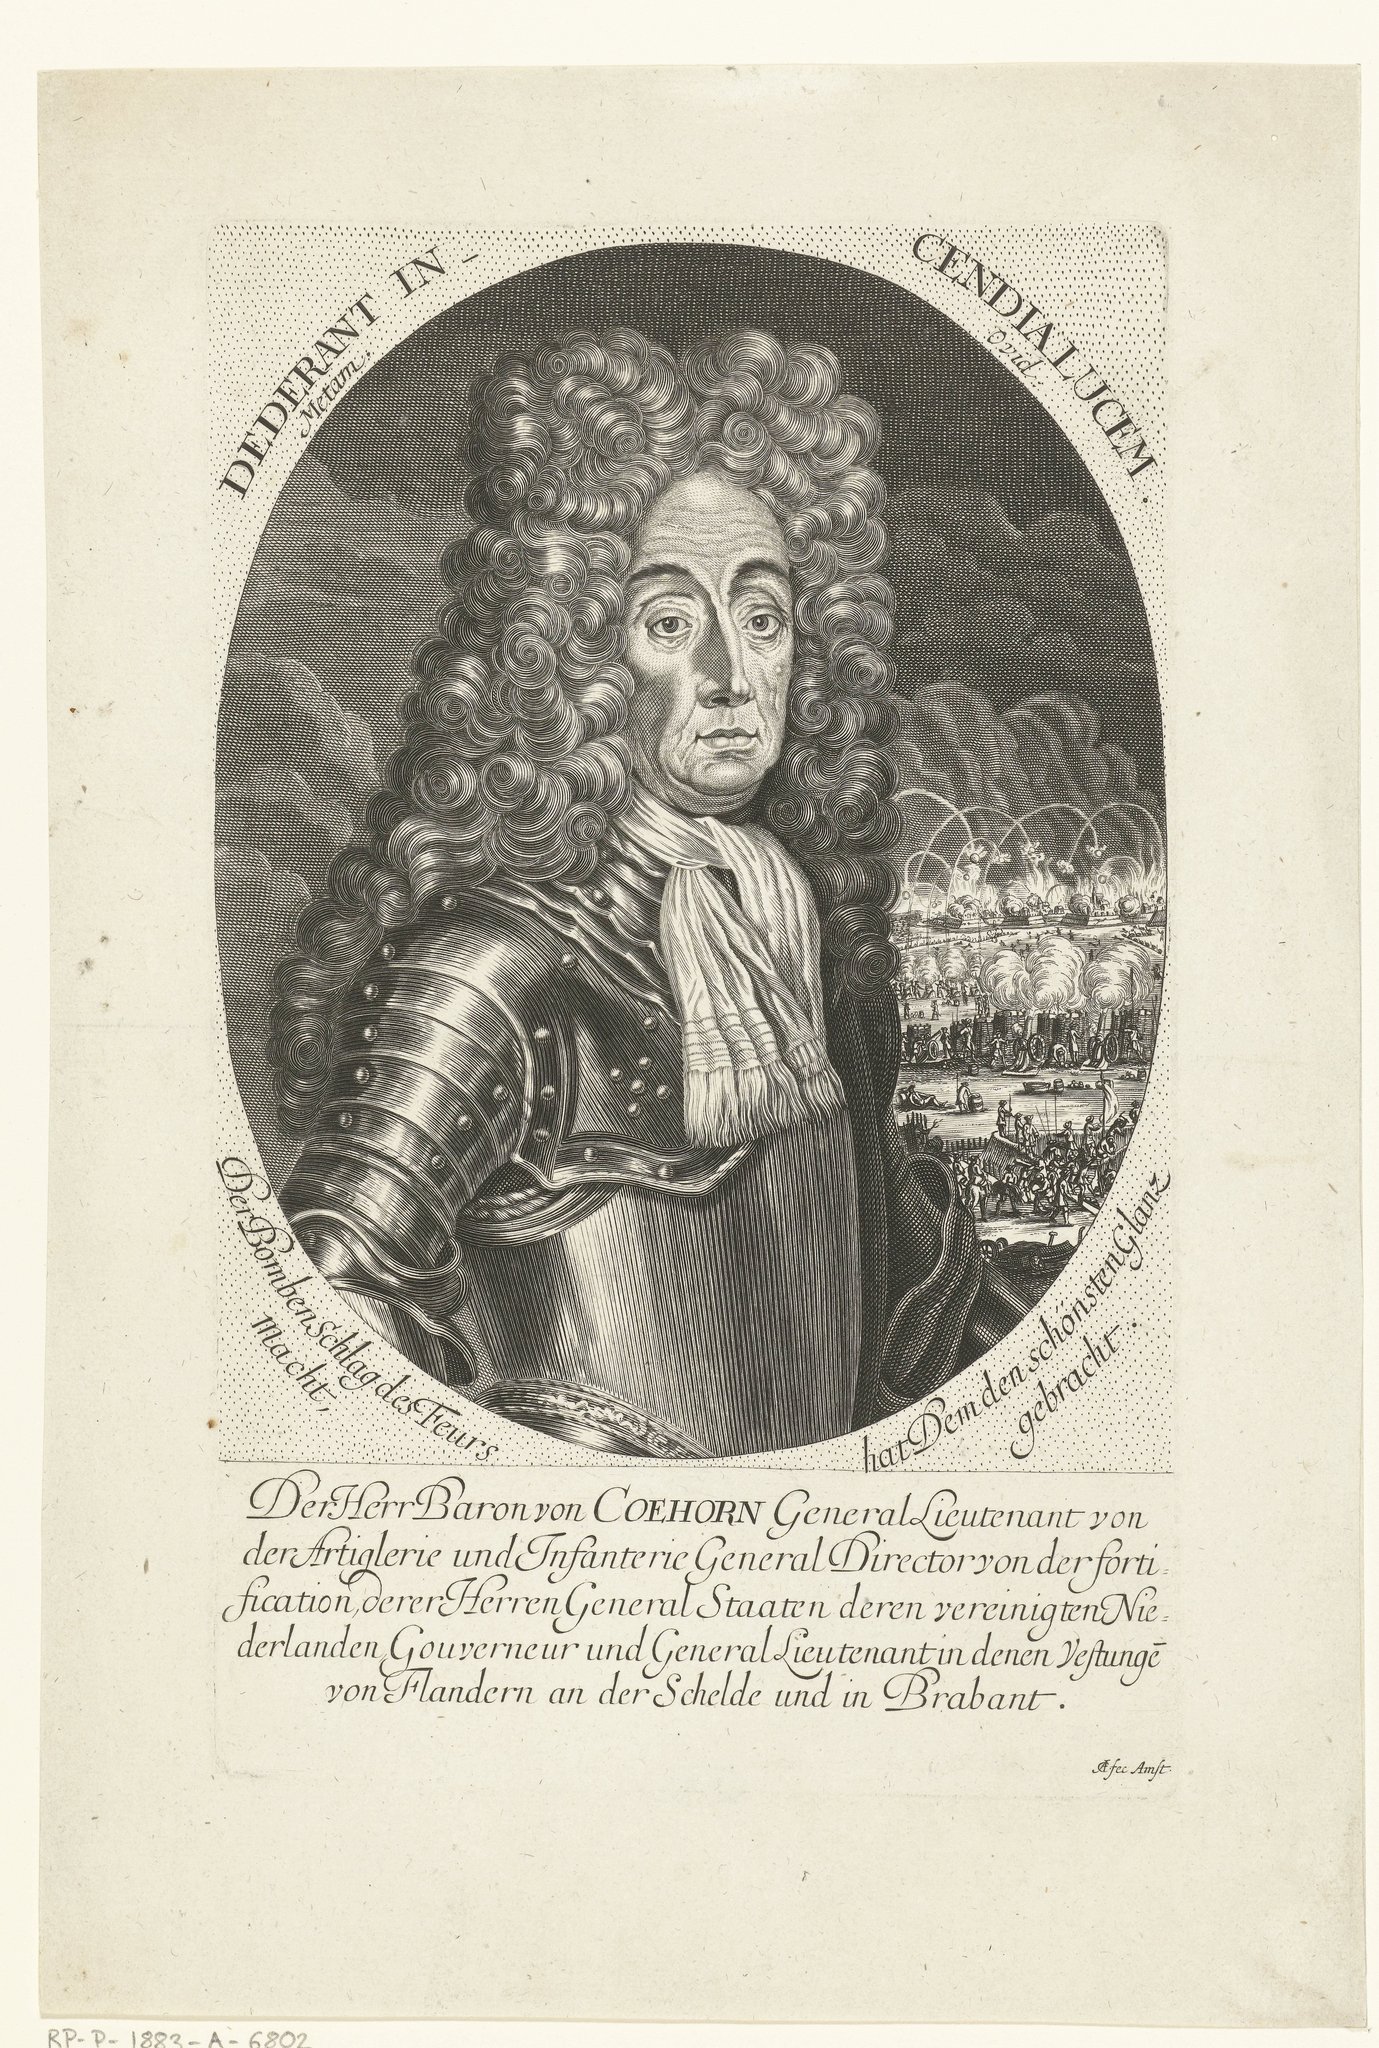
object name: print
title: Portret van baron Menno van Coehoorn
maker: cornelis apeus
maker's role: print maker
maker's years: 1634-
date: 1665-1688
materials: paper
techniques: engraving, etching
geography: amsterdam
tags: the hague, being attacked; defence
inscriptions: collector's mark: Lugt 2228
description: Portret van de vestingbouwkundige baron Menno van Coehoorn met rechts op de achtergrond een belegering van een vesting. Onder het portret de namen en titels in het Duits.